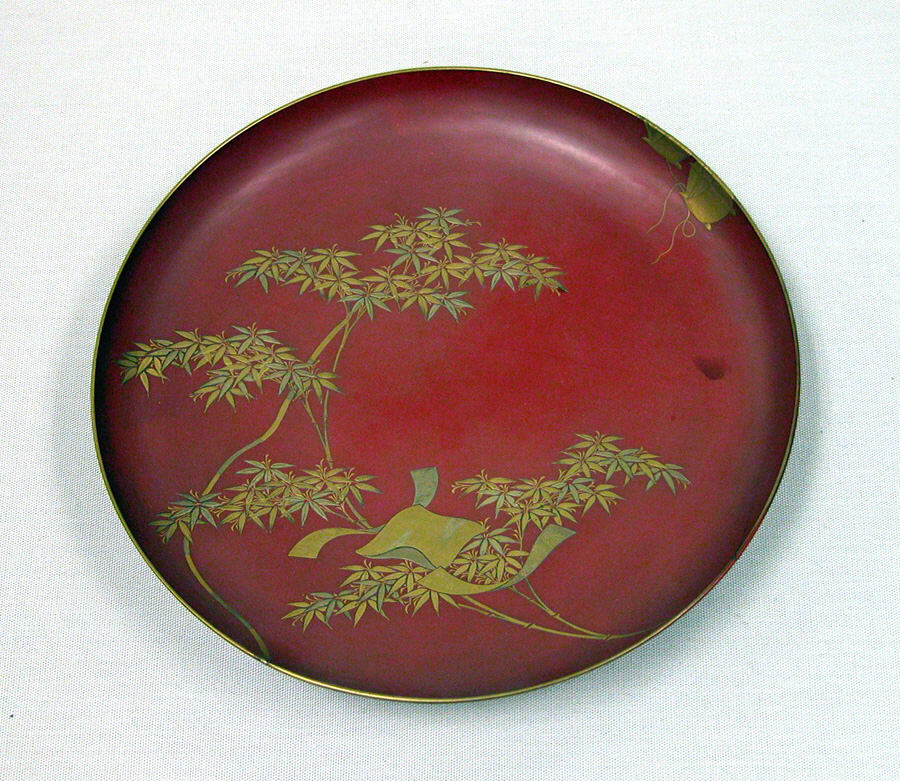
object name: wine cup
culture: japanese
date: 1834-1866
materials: gold, lacquer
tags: leaves